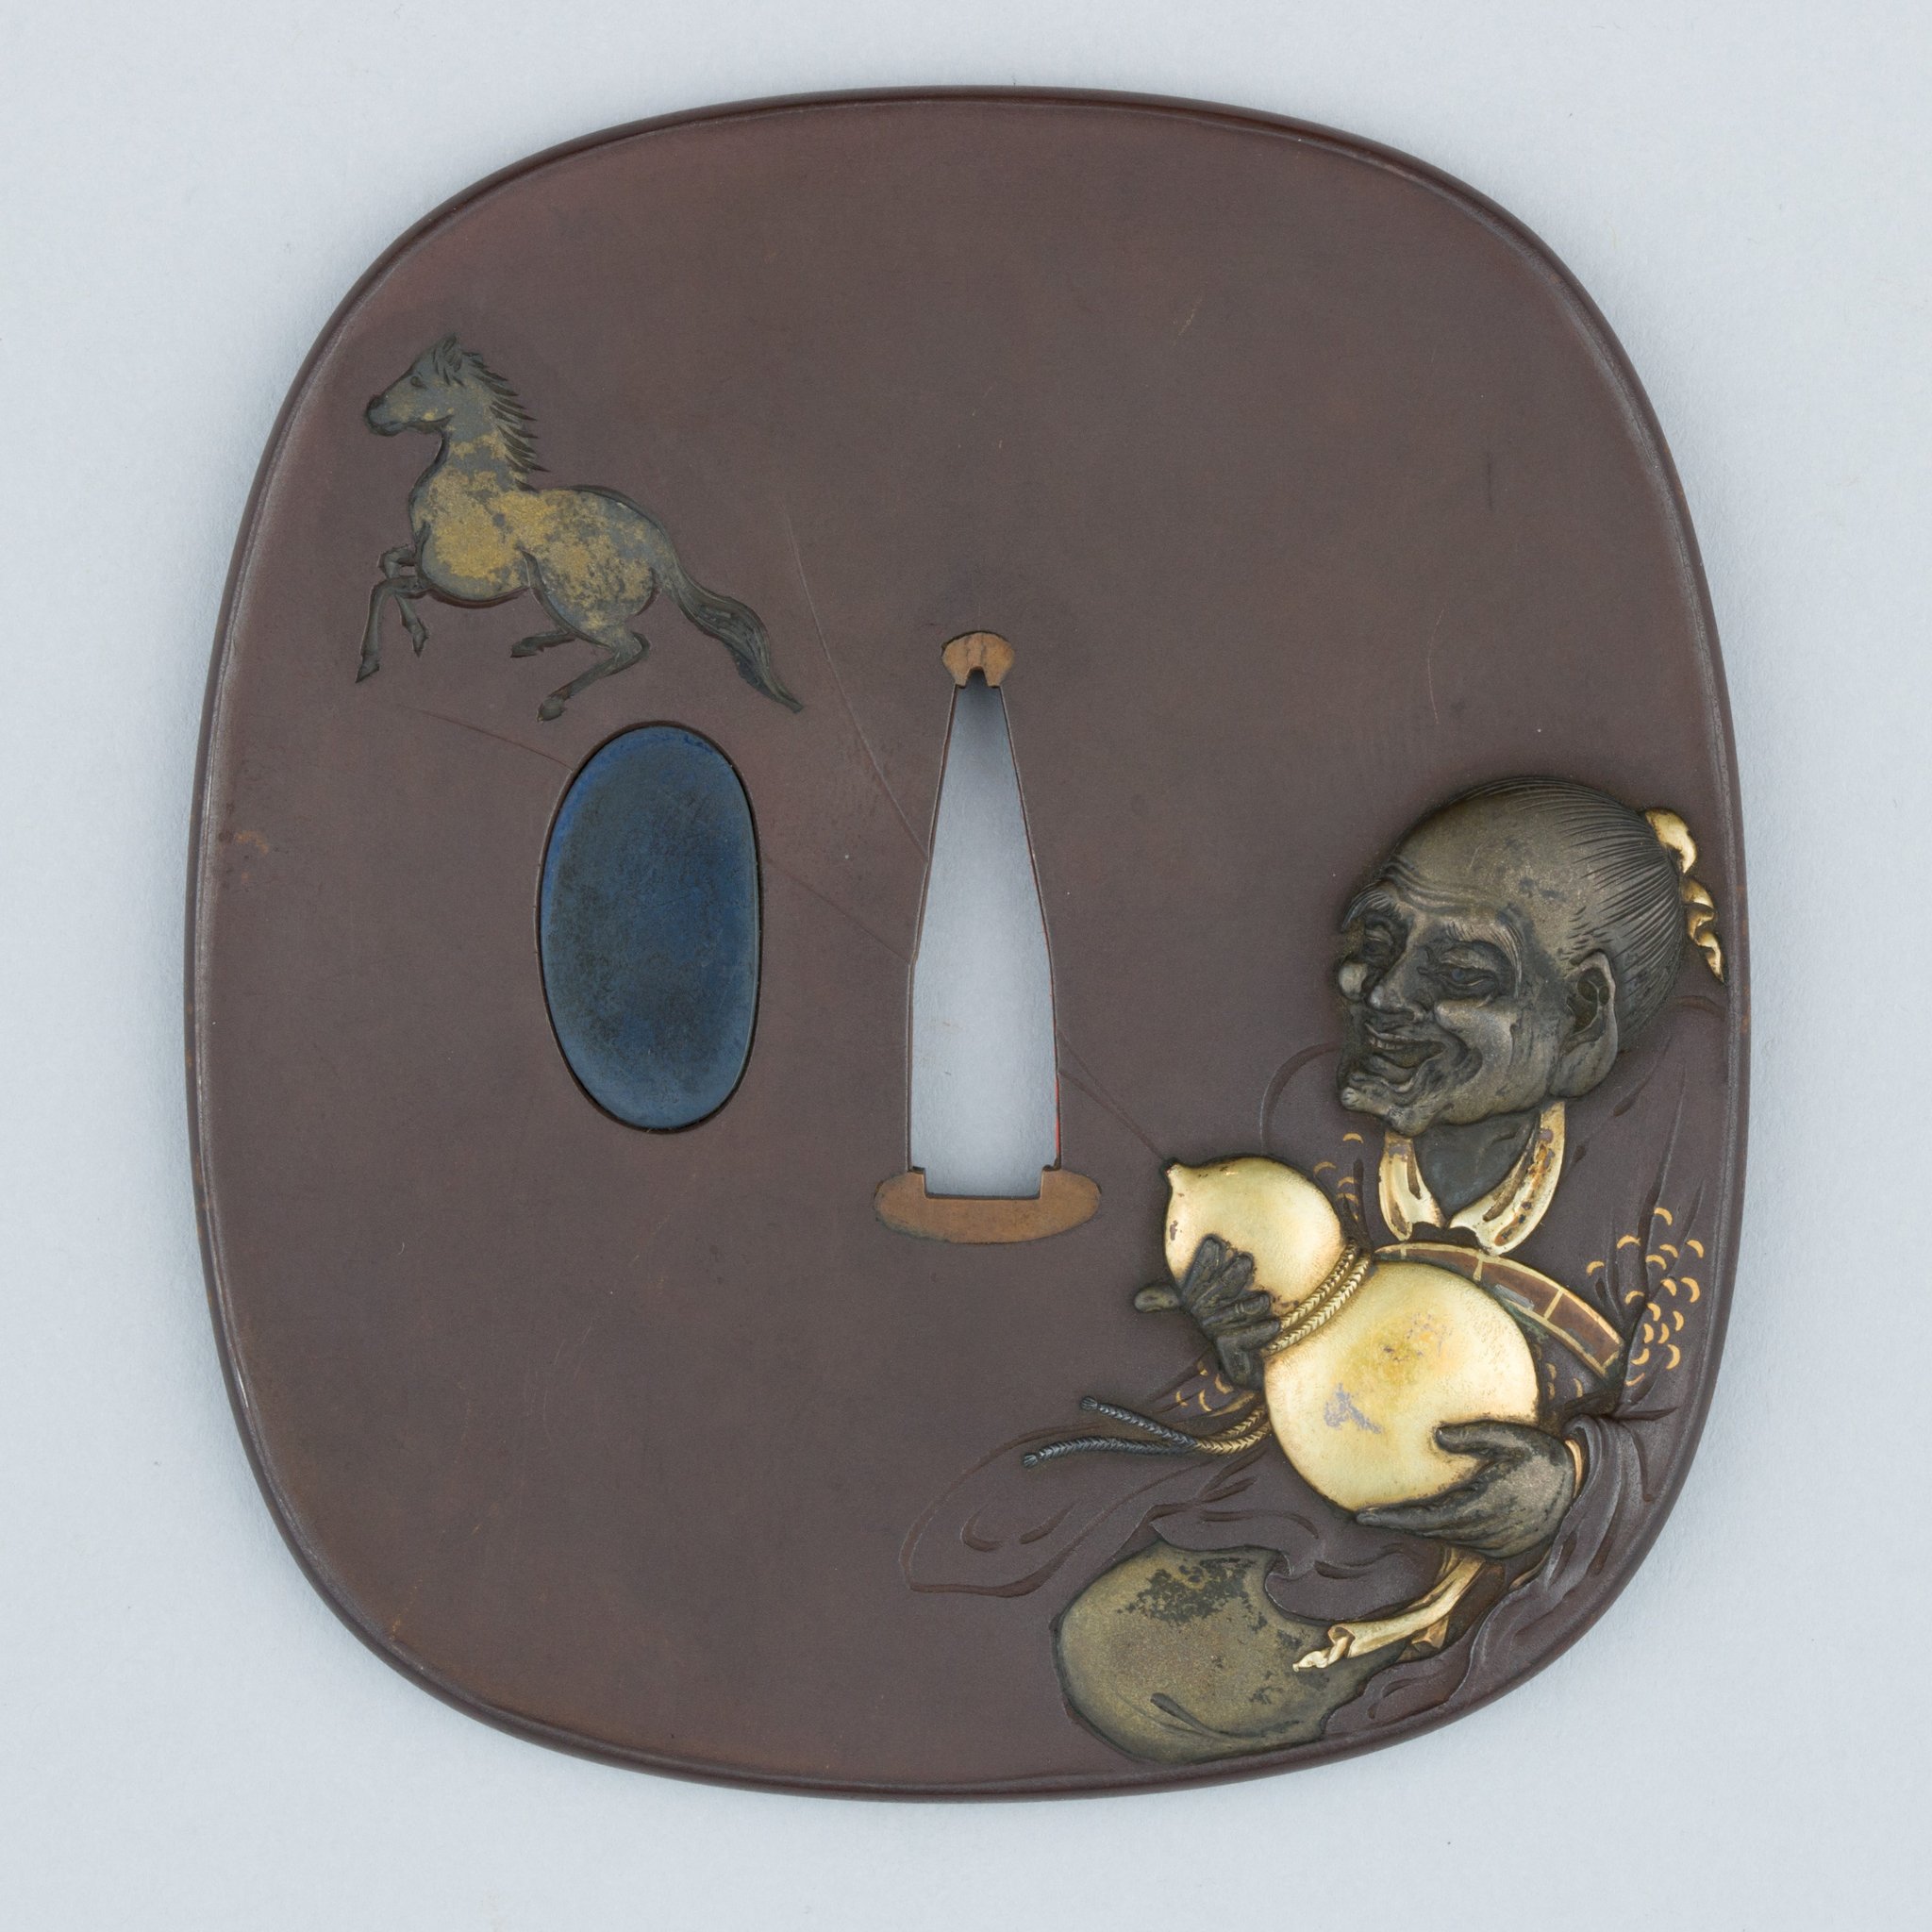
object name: sword guard tsuba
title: Sword Guard (Tsuba)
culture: japanese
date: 1615-1868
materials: copper, silver alloy, gold, iron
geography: japan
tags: men,horses